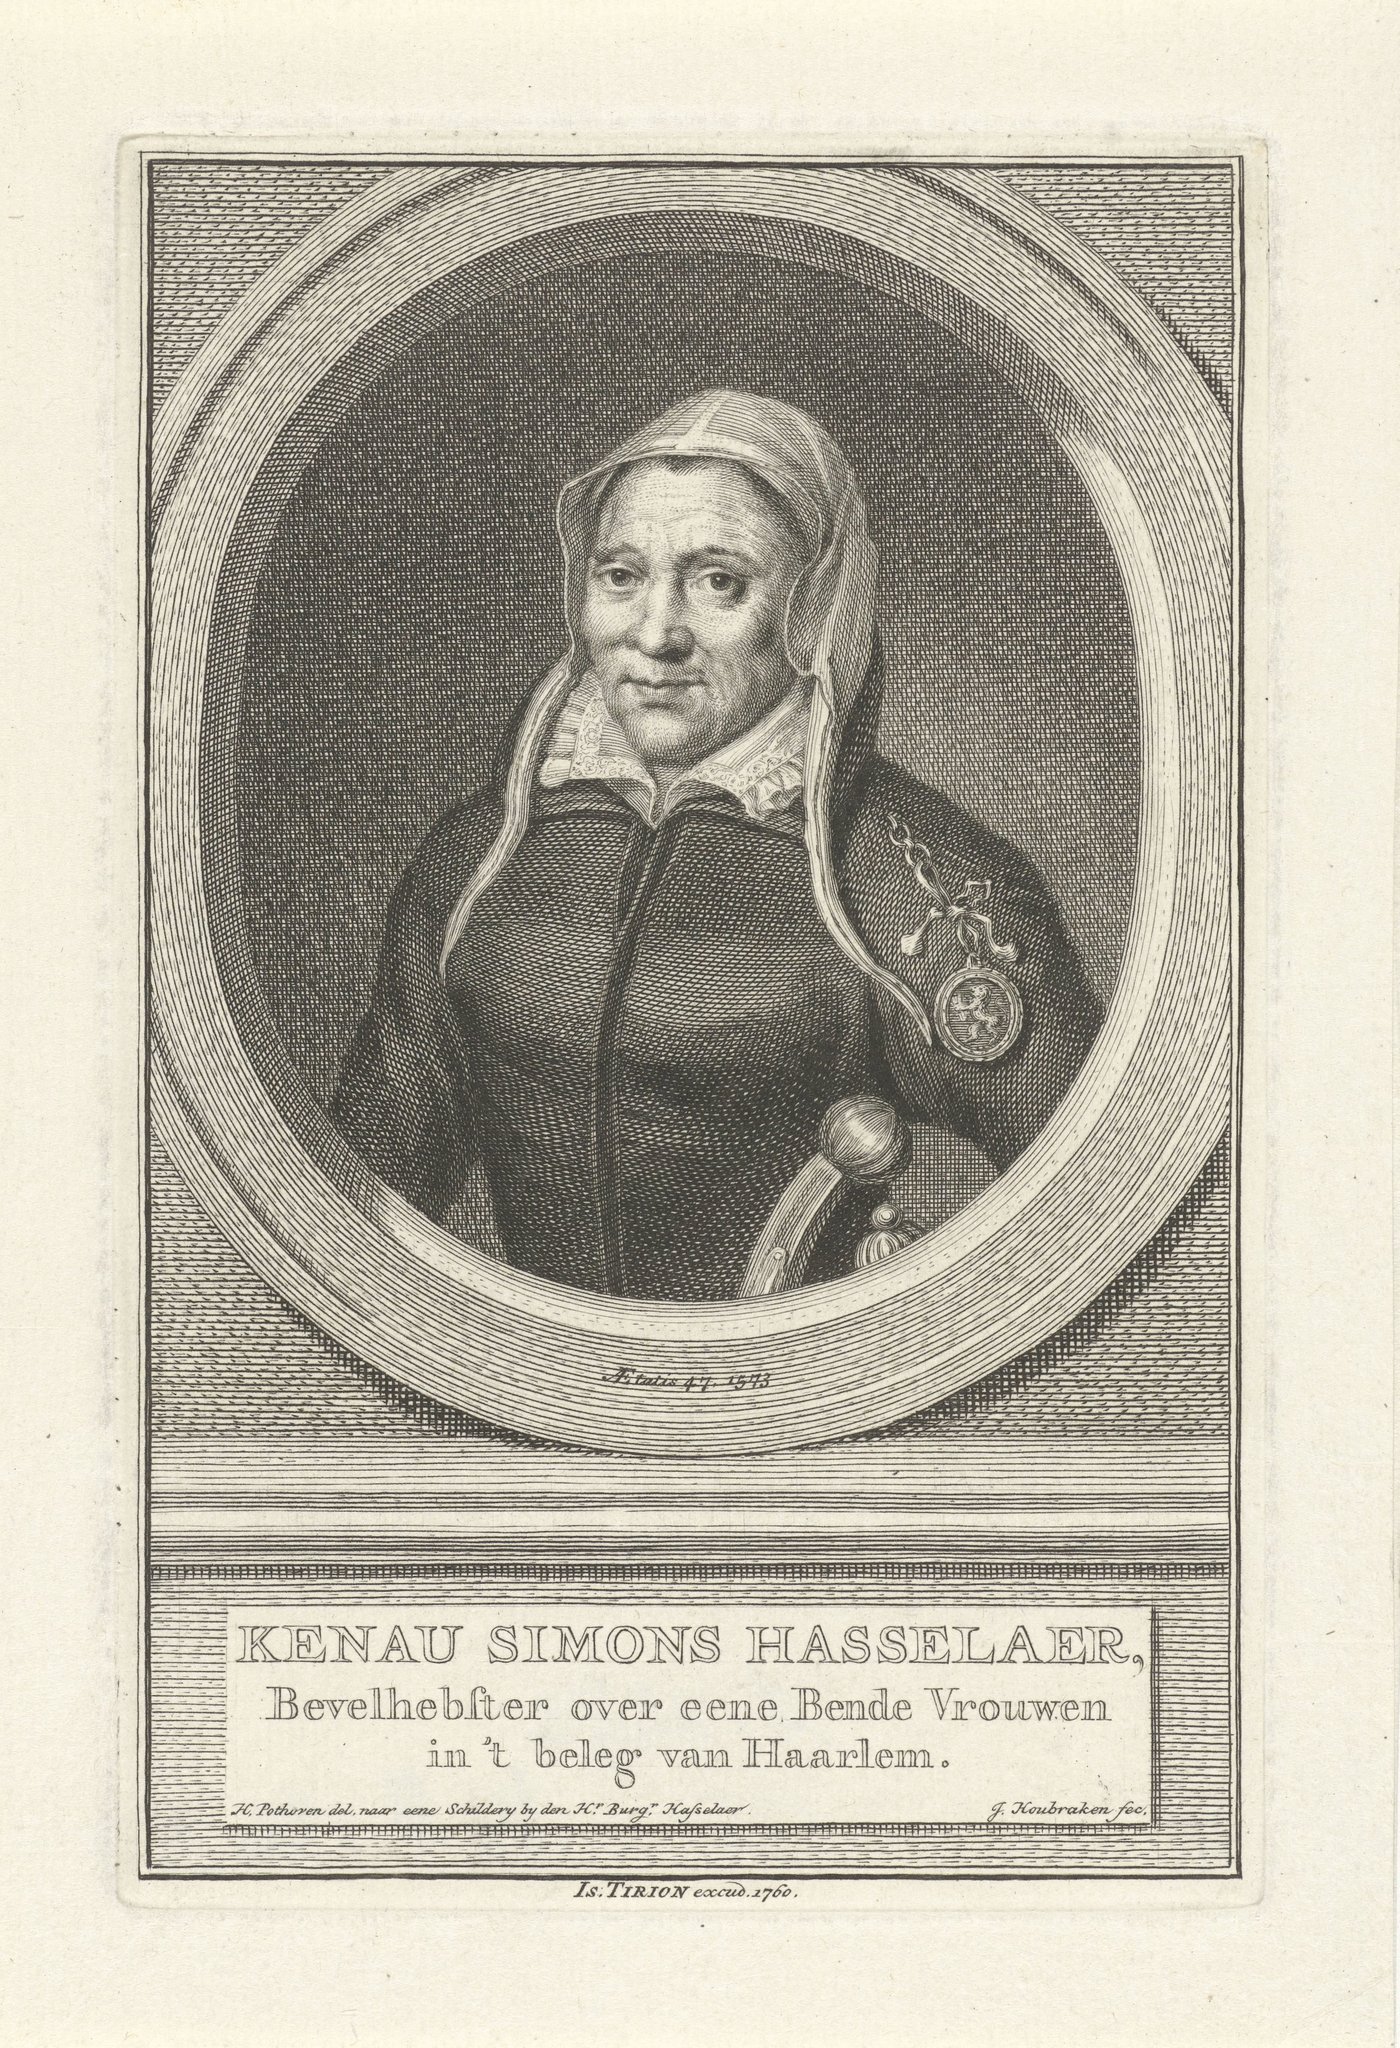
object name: print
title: Kenau Simons Hasselaer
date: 1760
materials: paper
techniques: engraving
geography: amsterdam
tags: kenau simonsdochter hasselaer, beleg van haarlem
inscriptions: collector's mark: Lugt 2228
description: Portret van Kenau Simonsdochter Hasselaer op 47-jarige leeftijd in een ovaal. Op haar linkerarm heeft zij een medaillon met de Hollandse Leeuw. Onder het portret haar naam en gegevens in drie regels in het Nederlands.